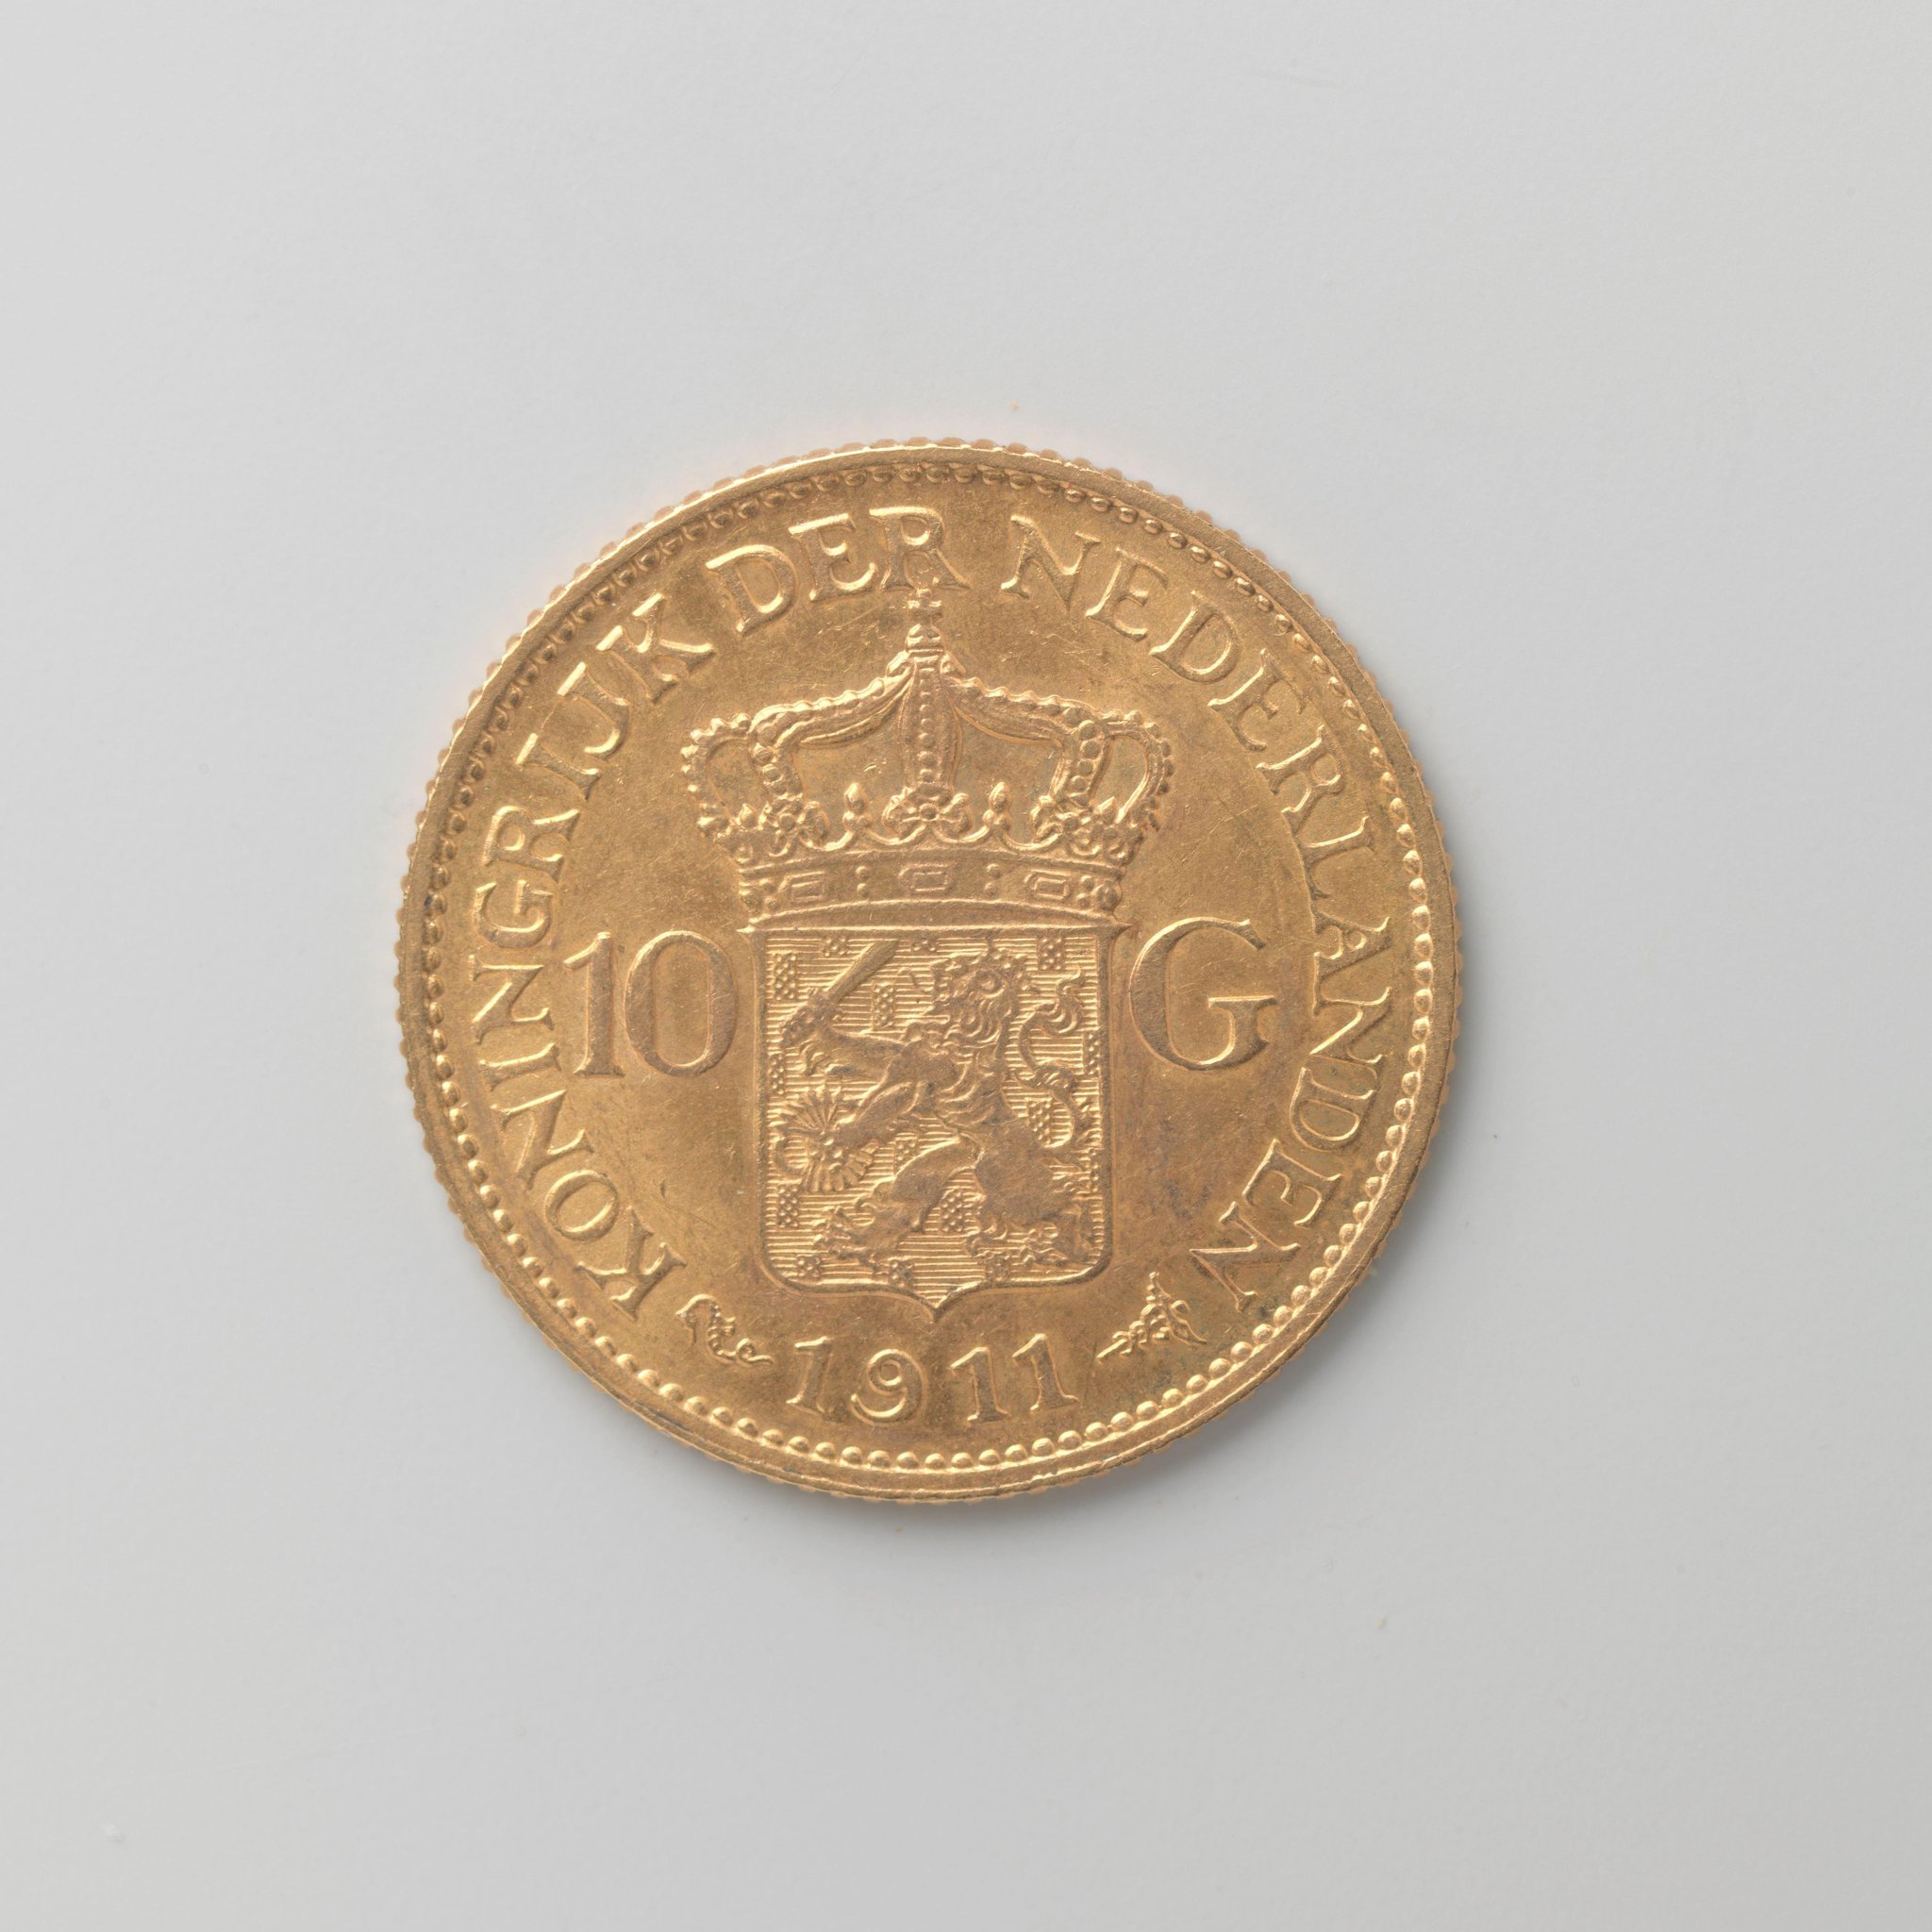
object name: coin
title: Nederlandse10 gulden,1911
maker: wilhelmina of the netherlands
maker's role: print maker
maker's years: 1880-1962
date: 1911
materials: gold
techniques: striking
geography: utrecht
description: Gouden munt. Voorzijde: gedrapeerd borstbeeld met diadeem naar rechts. Keerzijde: tussen waarde-aanduiding 10 G gekroond rijkswapenschild. Jaartal onderaan in omschrift. Kartelrand.